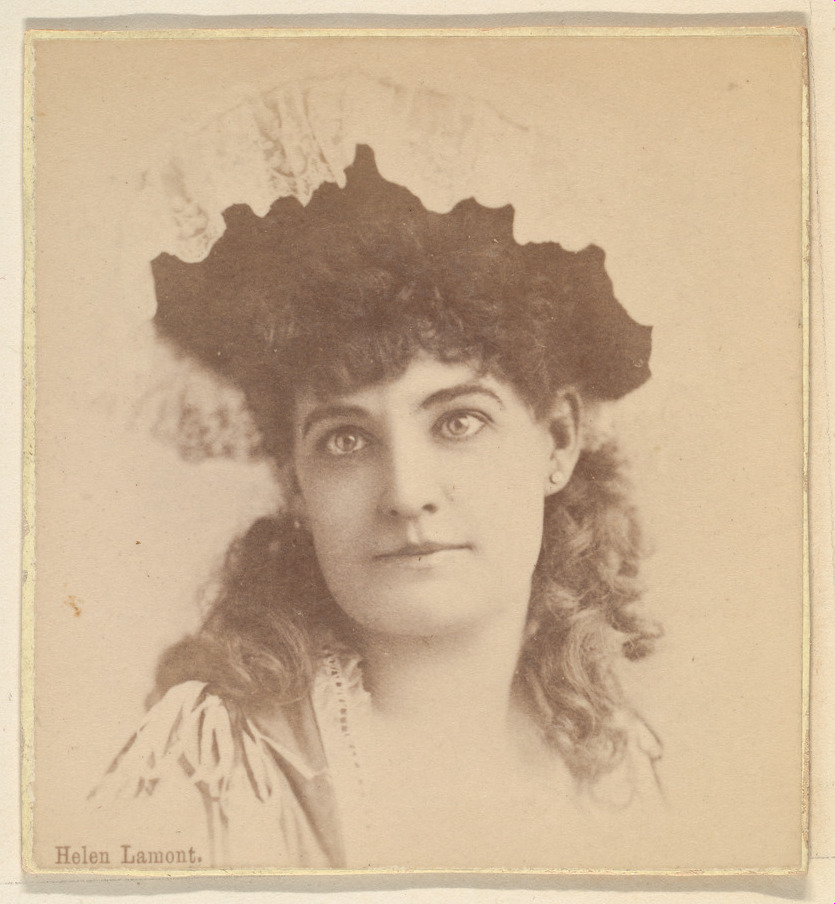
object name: photograph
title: Helen Lamont, from the Actresses series (N246), Type 2, issued by Kinney Brothers to promote Sporting Extra Cigarettes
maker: kinney brothers tobacco company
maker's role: publisher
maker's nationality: american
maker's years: 1869-2011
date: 1890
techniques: albumen silver print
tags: portraits,women,actresses